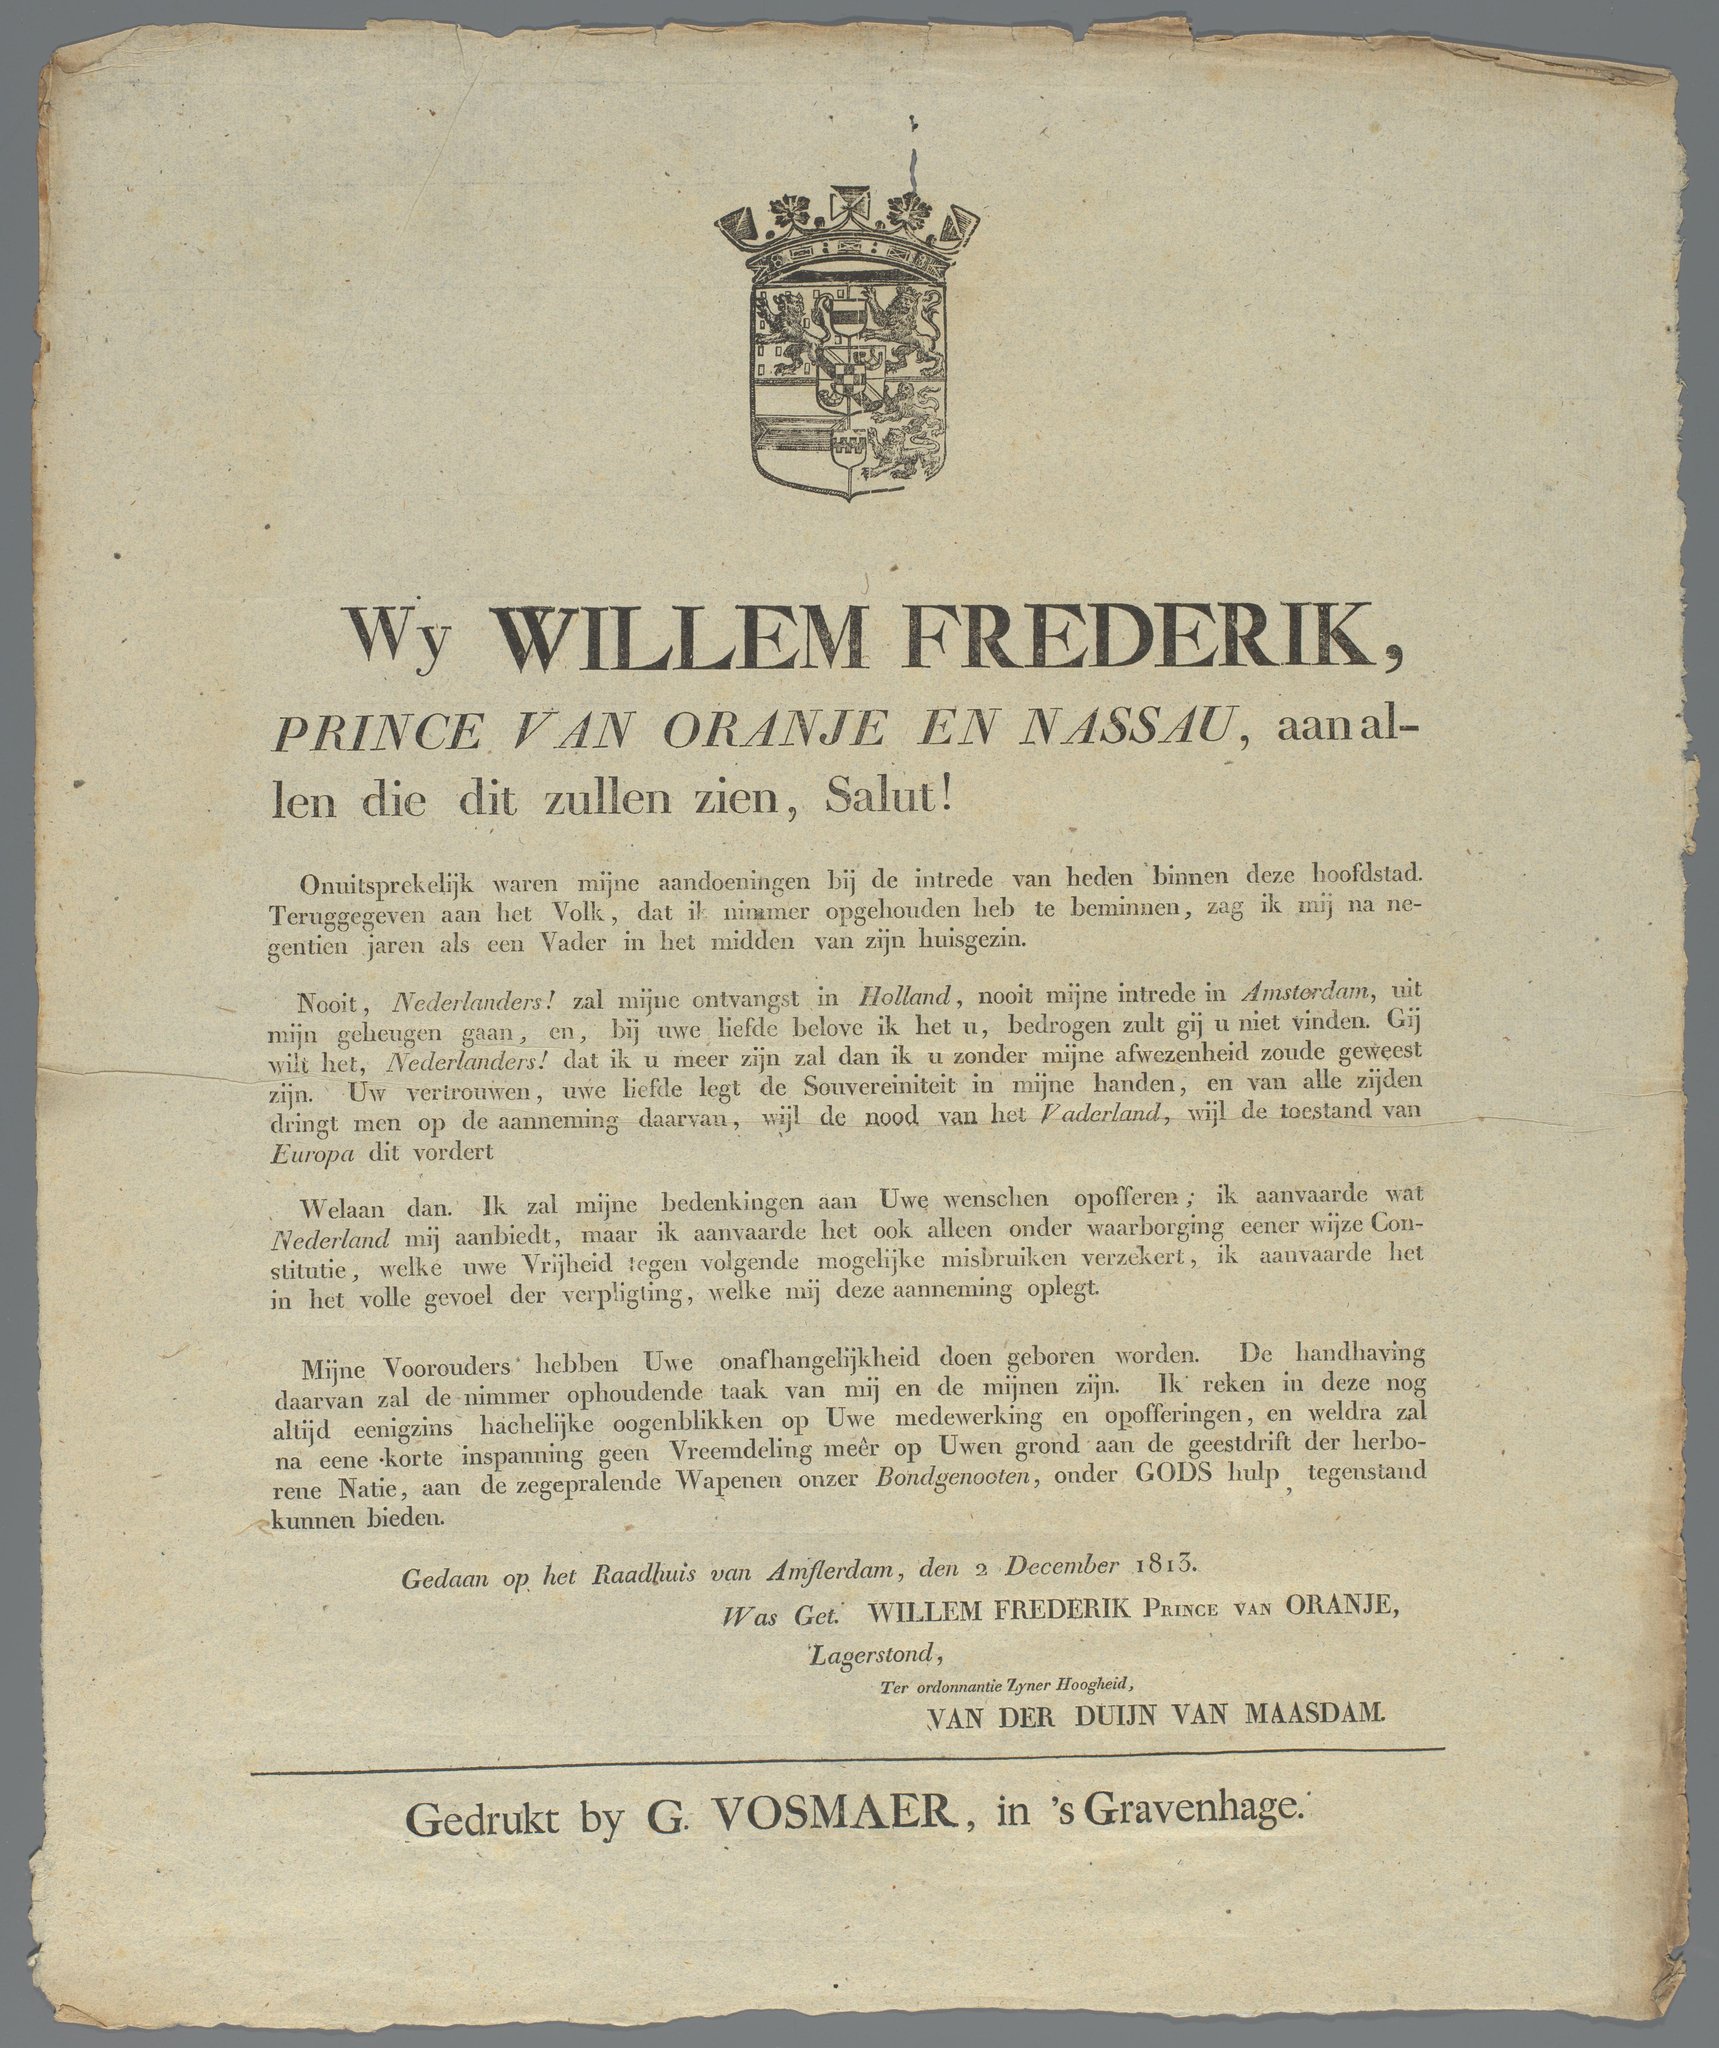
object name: proclamation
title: Proclamatie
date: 1813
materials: paper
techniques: printing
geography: the hague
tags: the hague, william i of the netherlands, netherlands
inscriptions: date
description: Proclamatie van Willem I, waarin deze mededeelt de souvereiniteit van Nederland te aanvaarden. Gedateerd; r.o.: 3 dec. 1813.